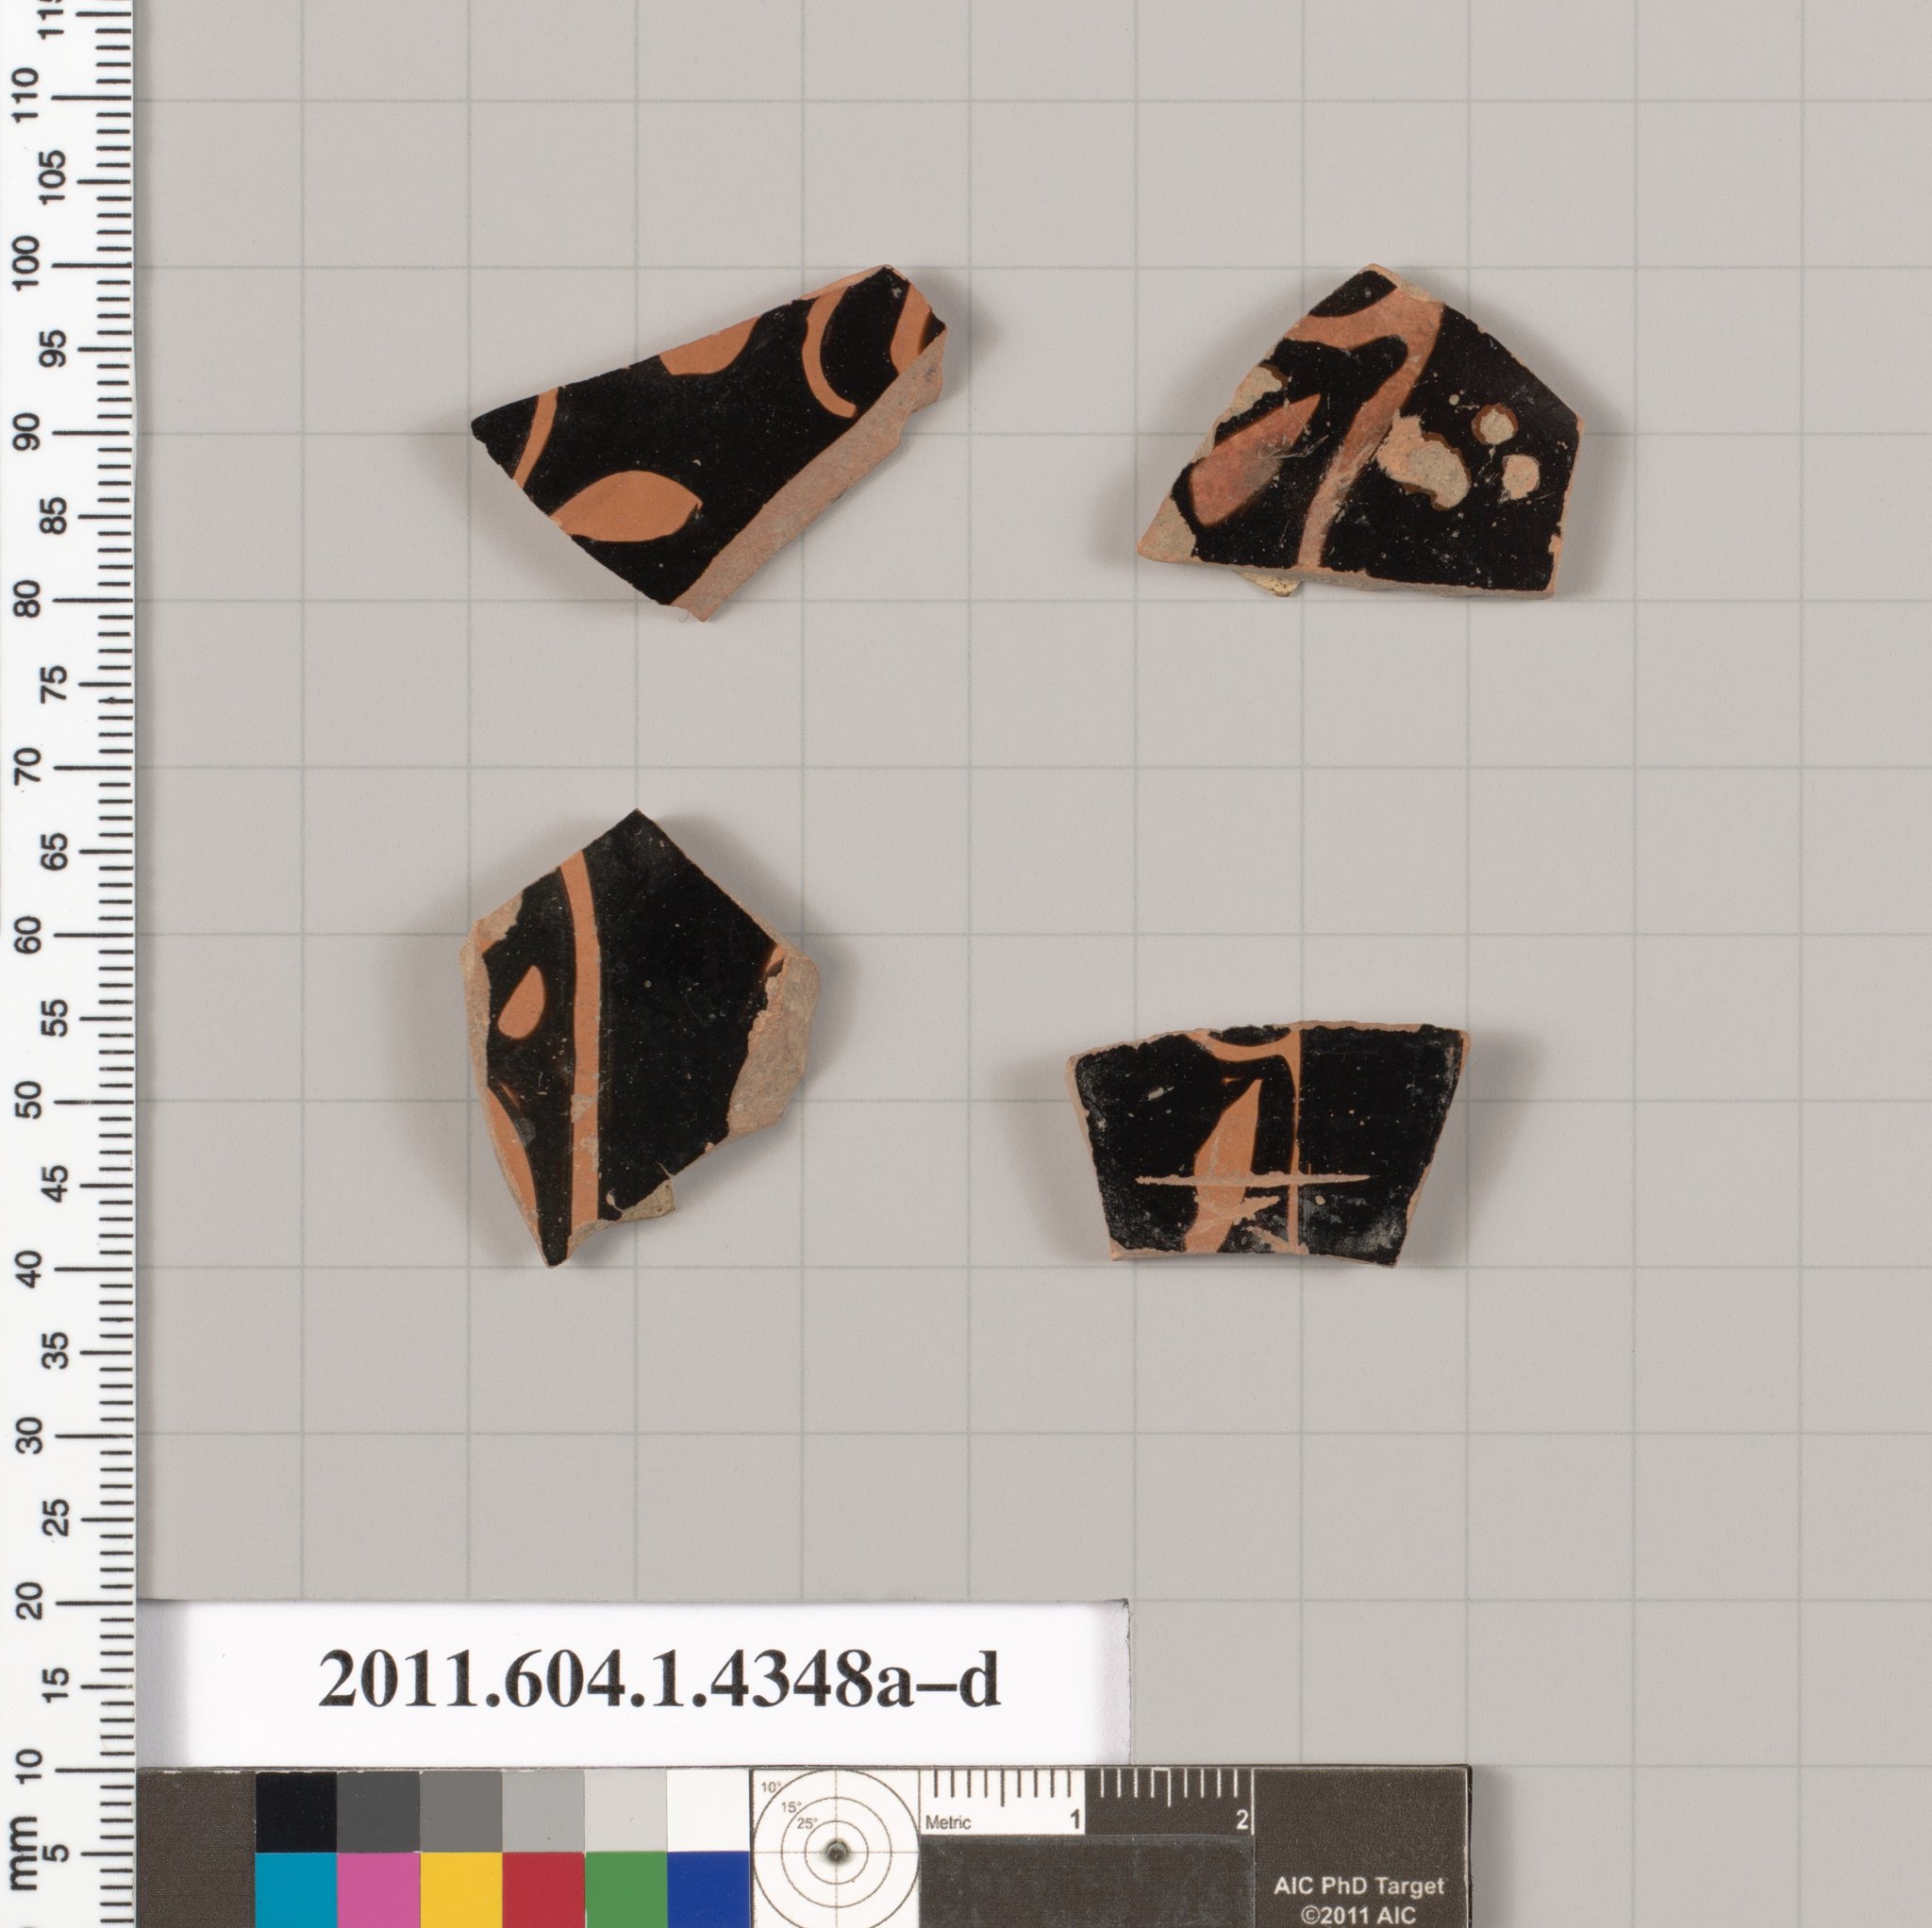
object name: kylix fragment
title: Terracotta fragments of kylikes (drinking cups)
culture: greek, attic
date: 475-451 BCE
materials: terracotta